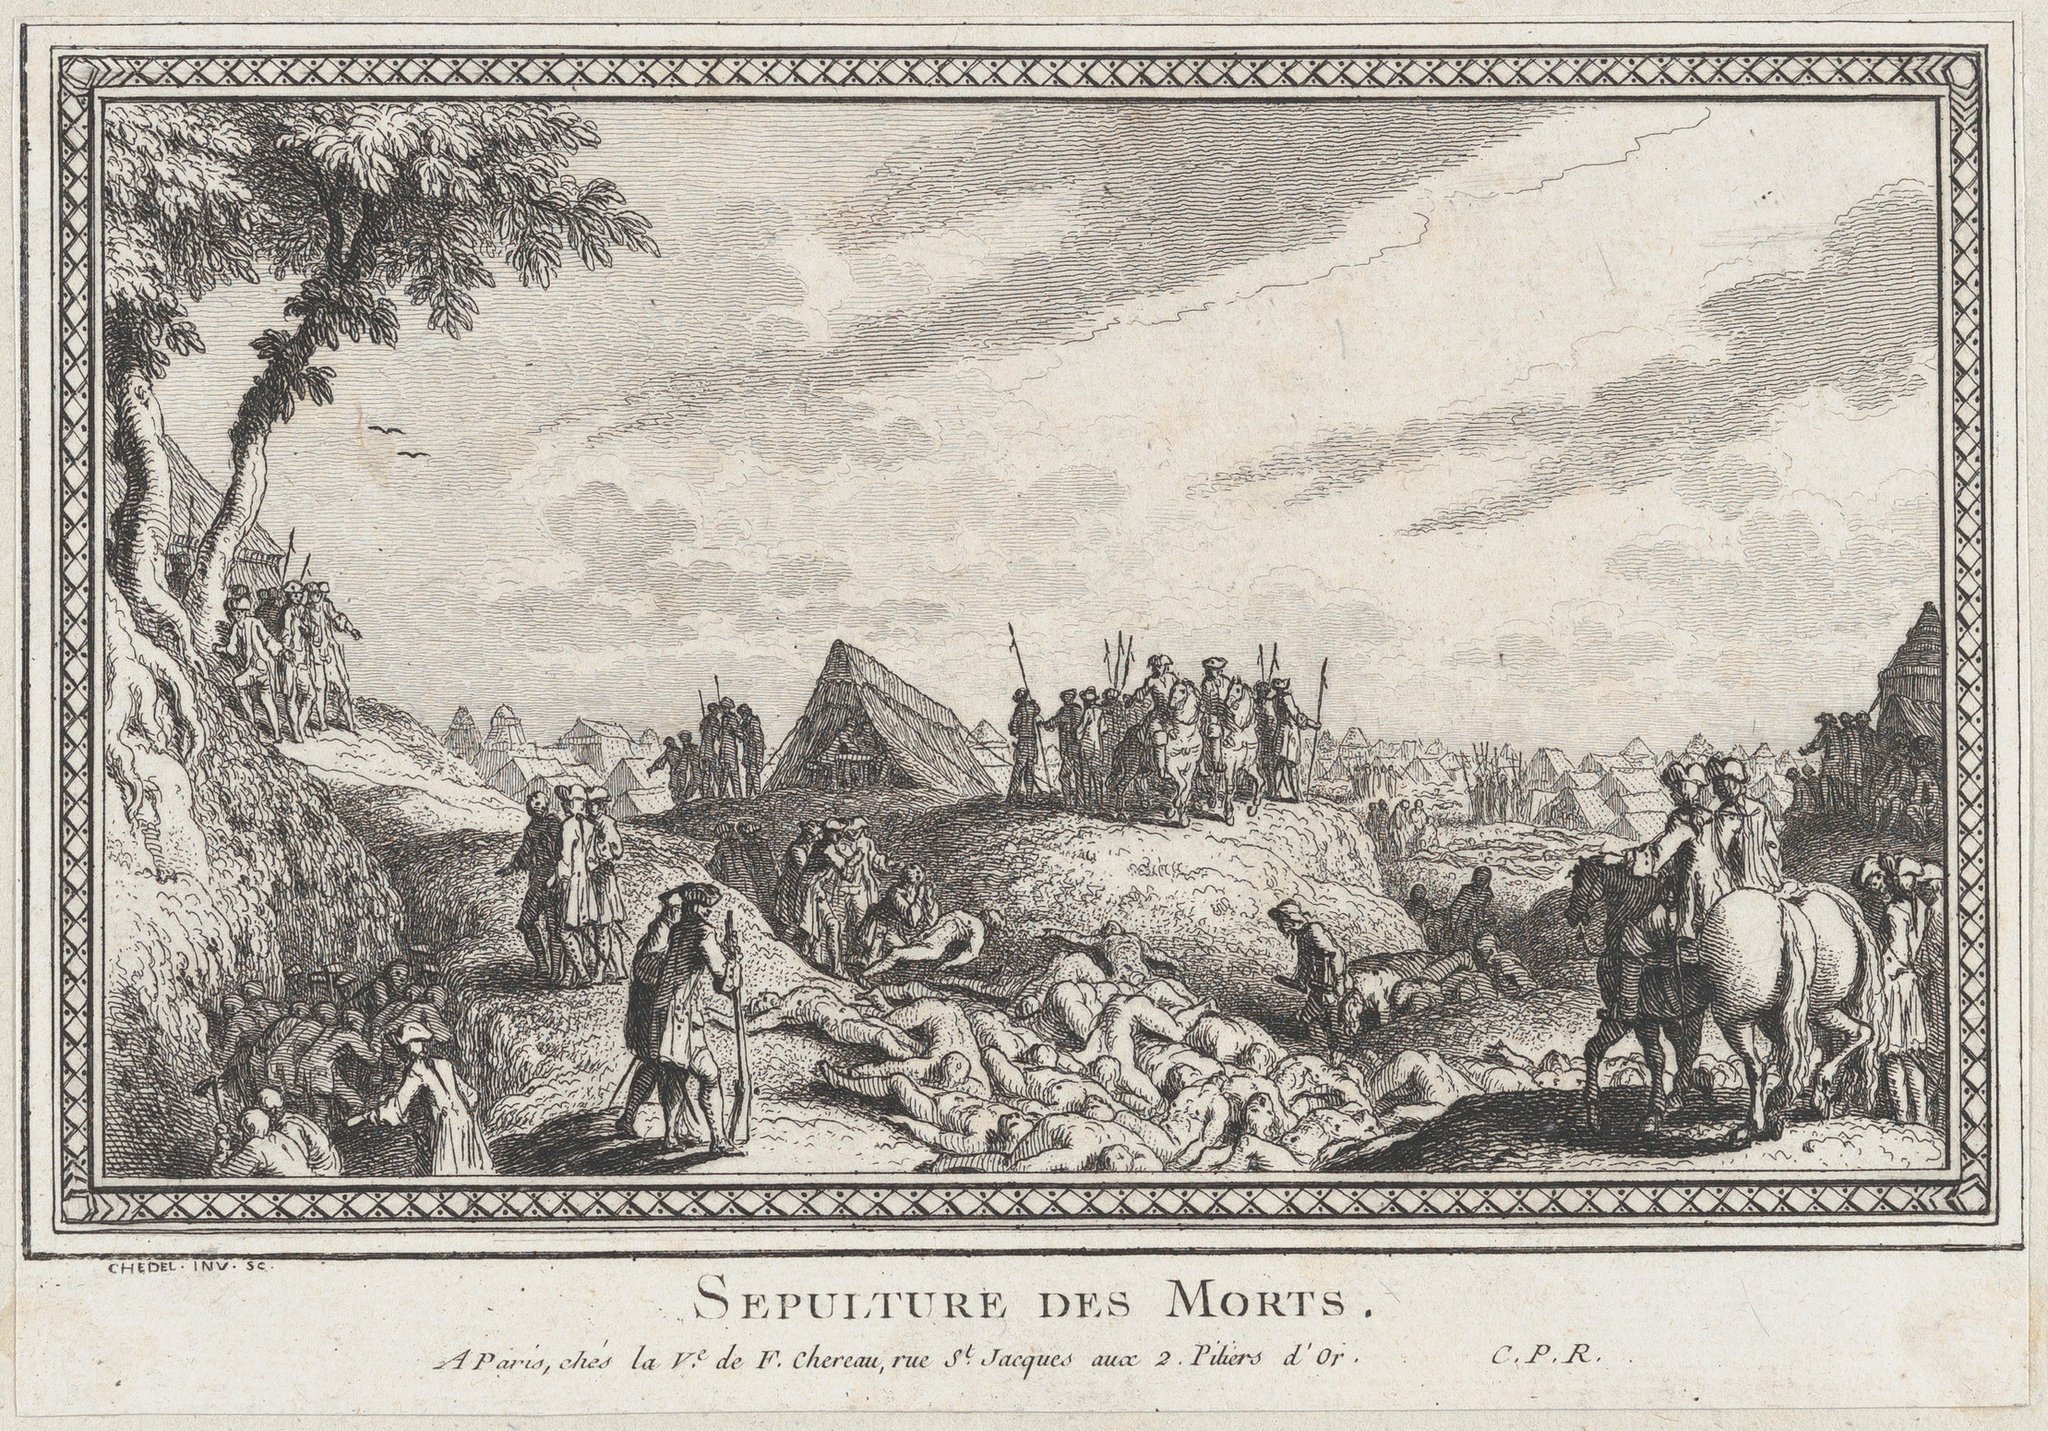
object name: print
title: Tombs of the Dead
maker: quentin pierre chedel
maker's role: artist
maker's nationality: french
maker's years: 1705-1763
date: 1701-1800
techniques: etching